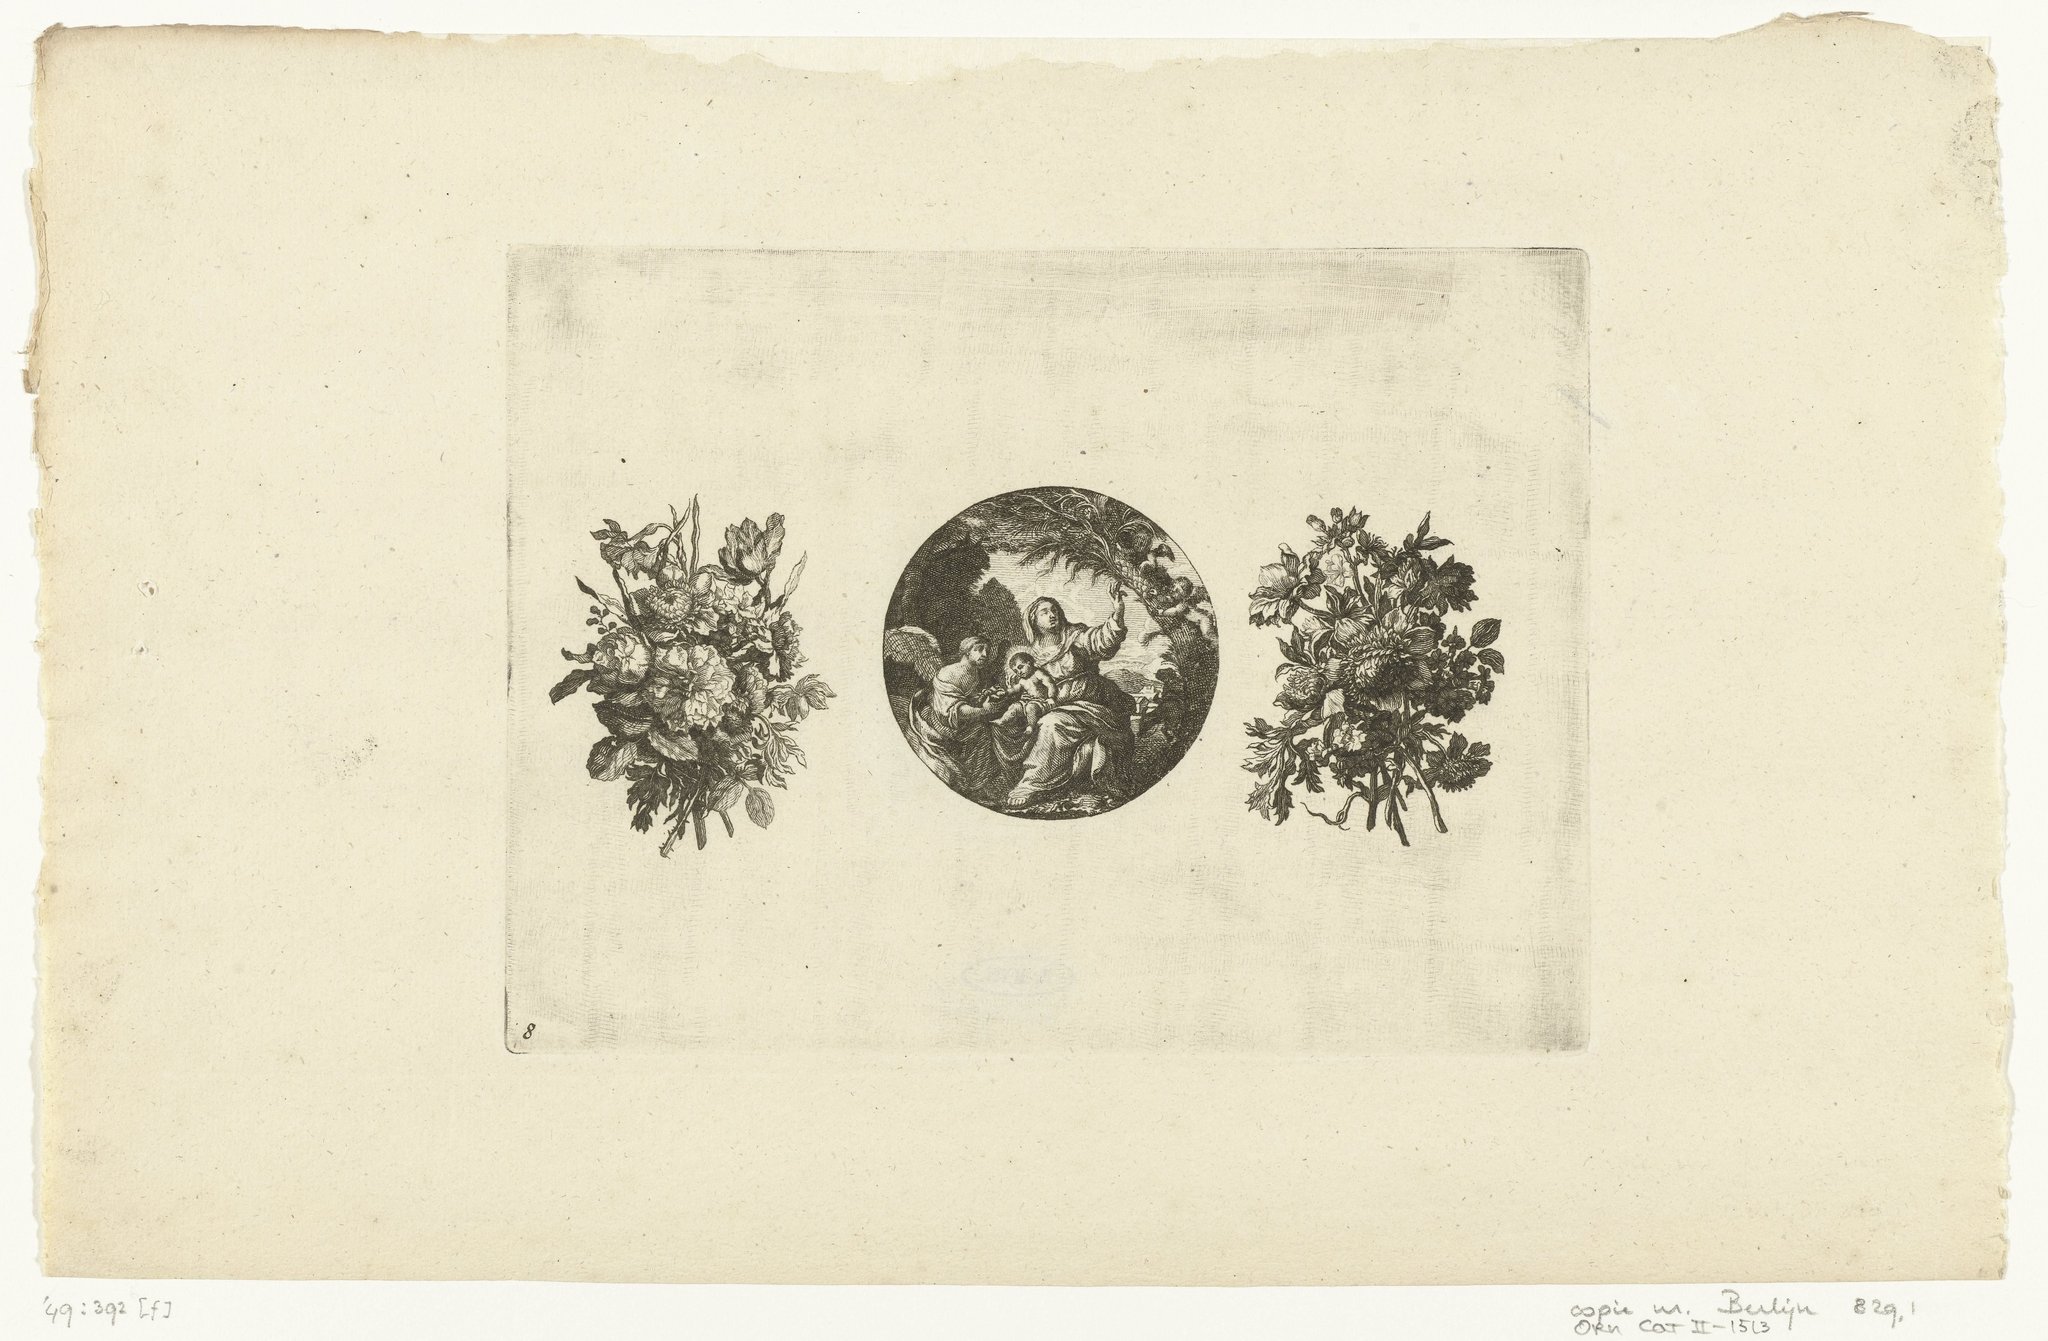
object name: ornament print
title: Horlogekast tussen twee boeketten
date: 1661-1726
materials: paper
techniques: engraving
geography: amsterdam